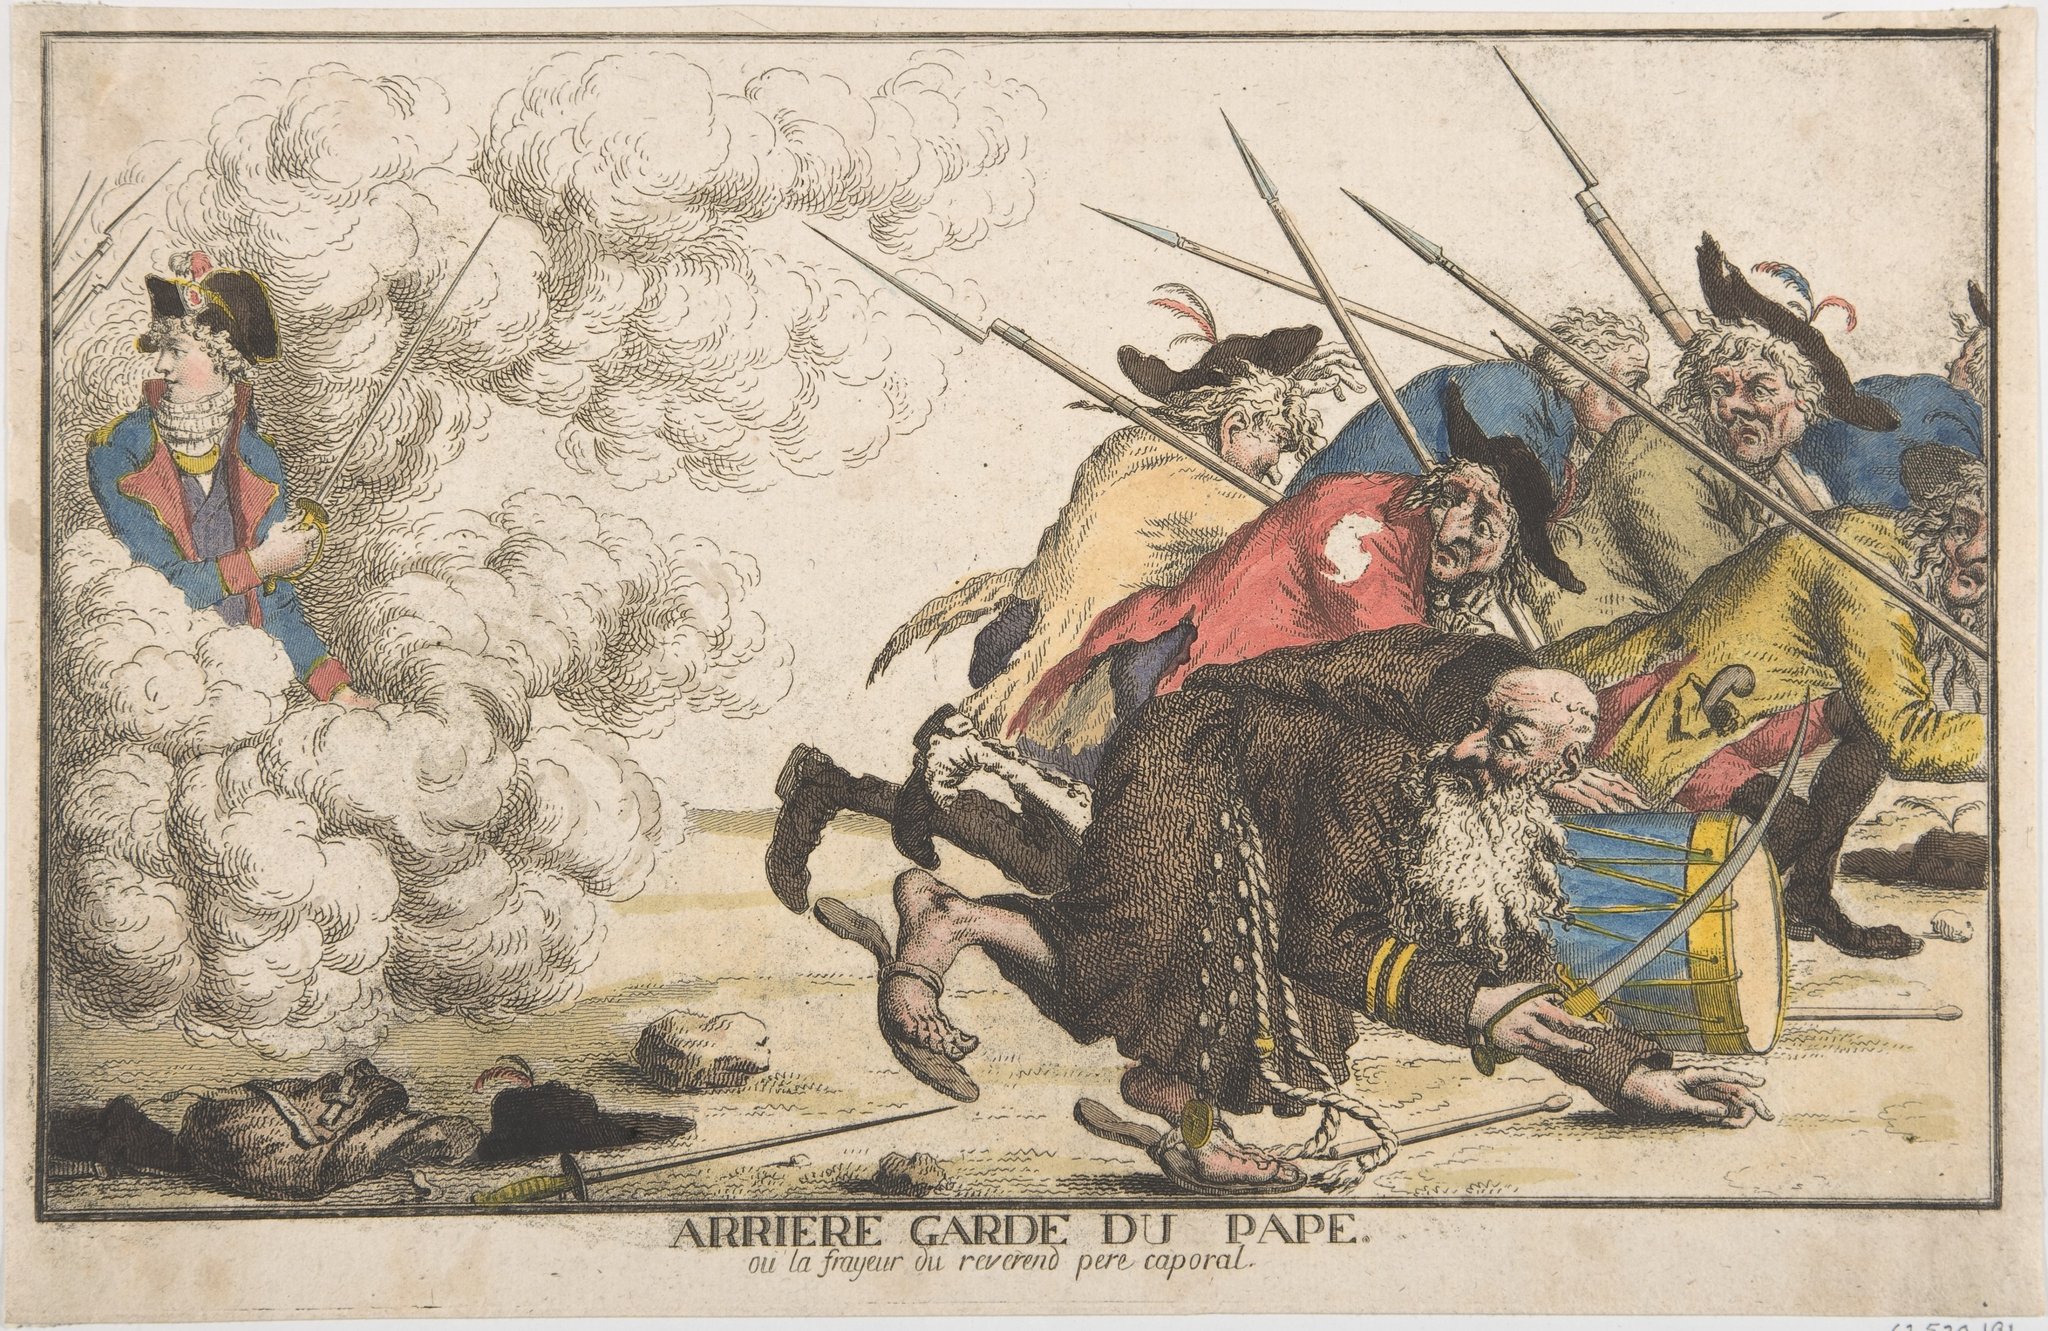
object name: print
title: The Pope's Rear Guard or the Fright of the Reverend Father Corporal (Arrière garde du pape, ou la frayeur du reverend pere caporal)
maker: anonymous, french, 18th century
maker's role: artist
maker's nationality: french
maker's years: 1700-1800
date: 1767-1800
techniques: etching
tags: soldiers,men,caricature